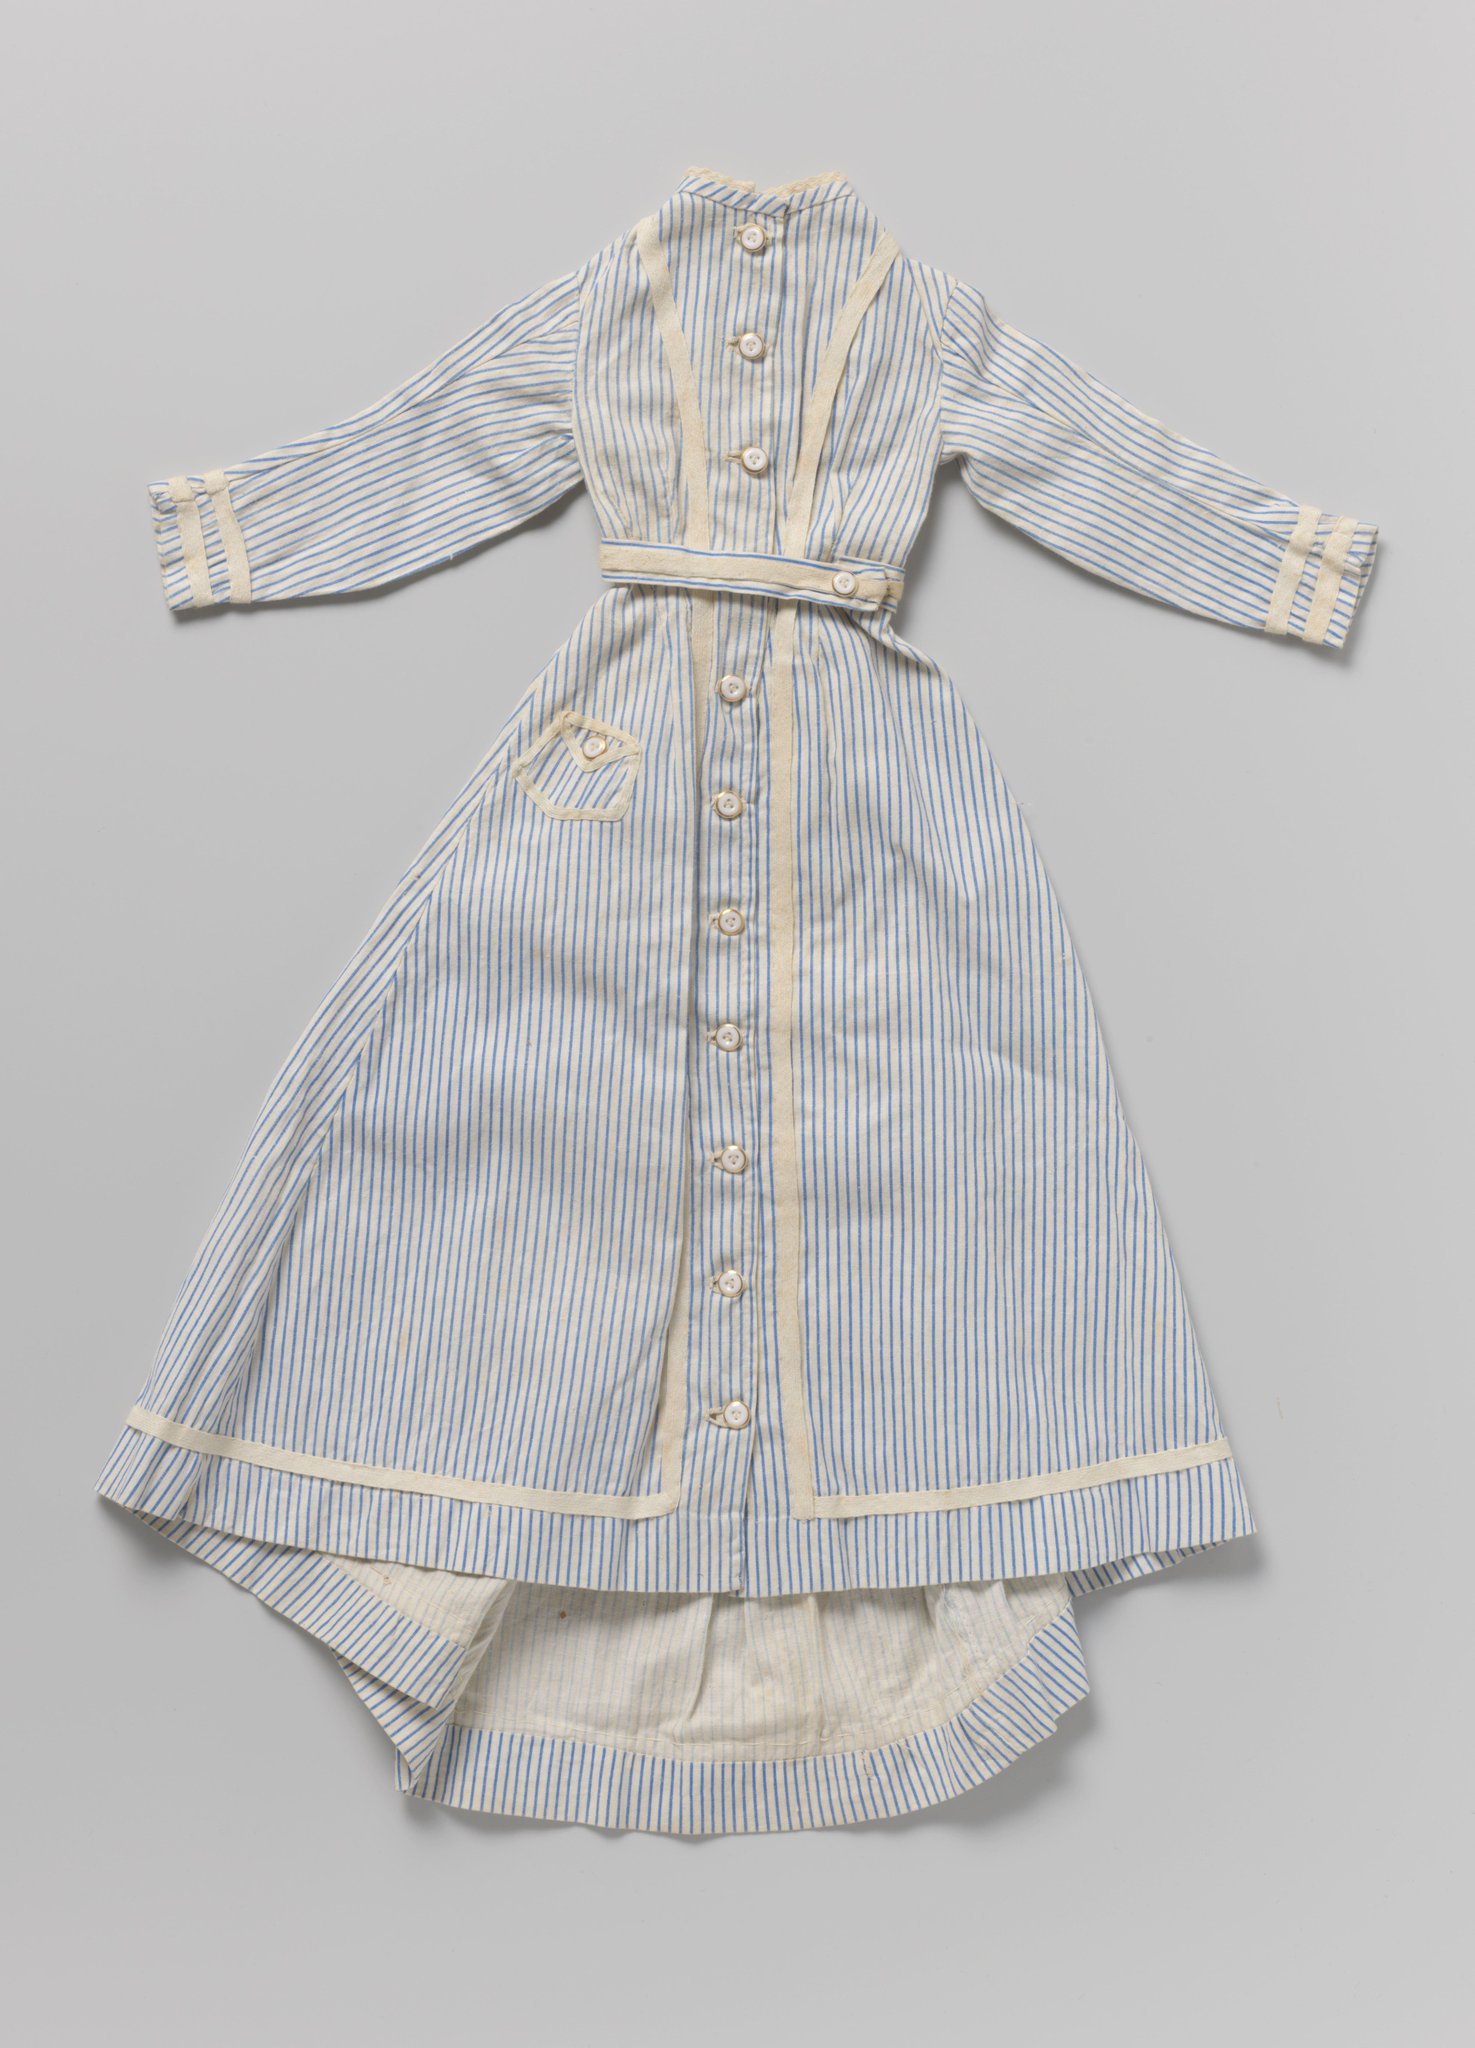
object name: robe, japon, jurk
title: Japon van blauw en wit gestreepte katoen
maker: Anonymous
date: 1870-1880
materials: cotton, plastic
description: Japon van blauw en wit gestreepte katoen. Behorende bij pop BK-15444.